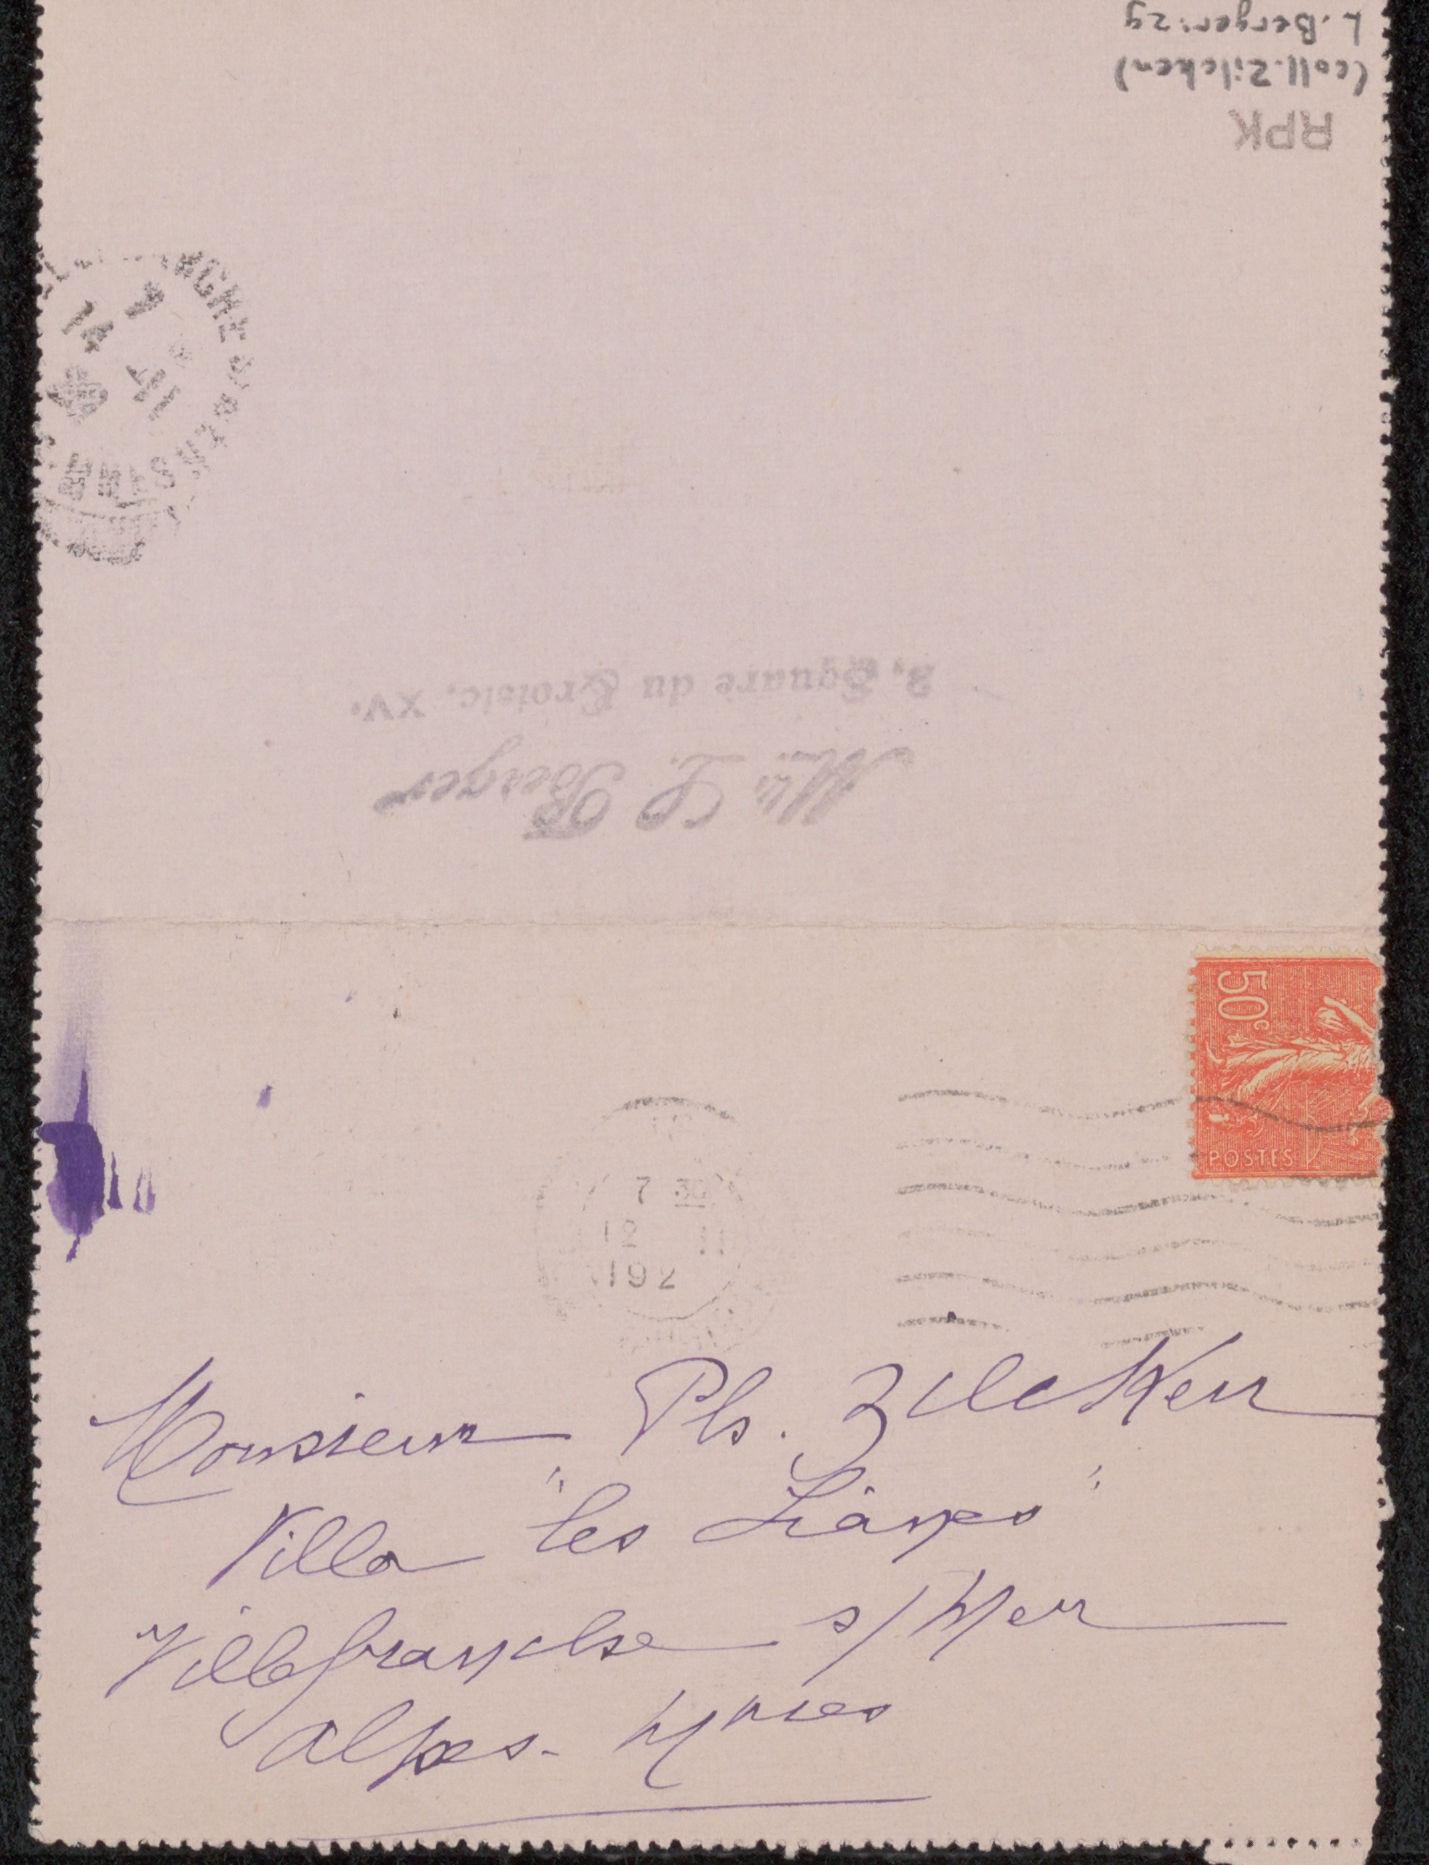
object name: letter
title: Brief aan Philip Zilcken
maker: lya berger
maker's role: schrijver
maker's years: 1877-1941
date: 1929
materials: ink, paper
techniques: pen, writing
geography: paris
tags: the hague, painter, draughtsman, philip zilcken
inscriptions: collector's mark: ‘RPK’, address: ‘Mlle. L. Berger/ 2, Square du Croisic, XVe’